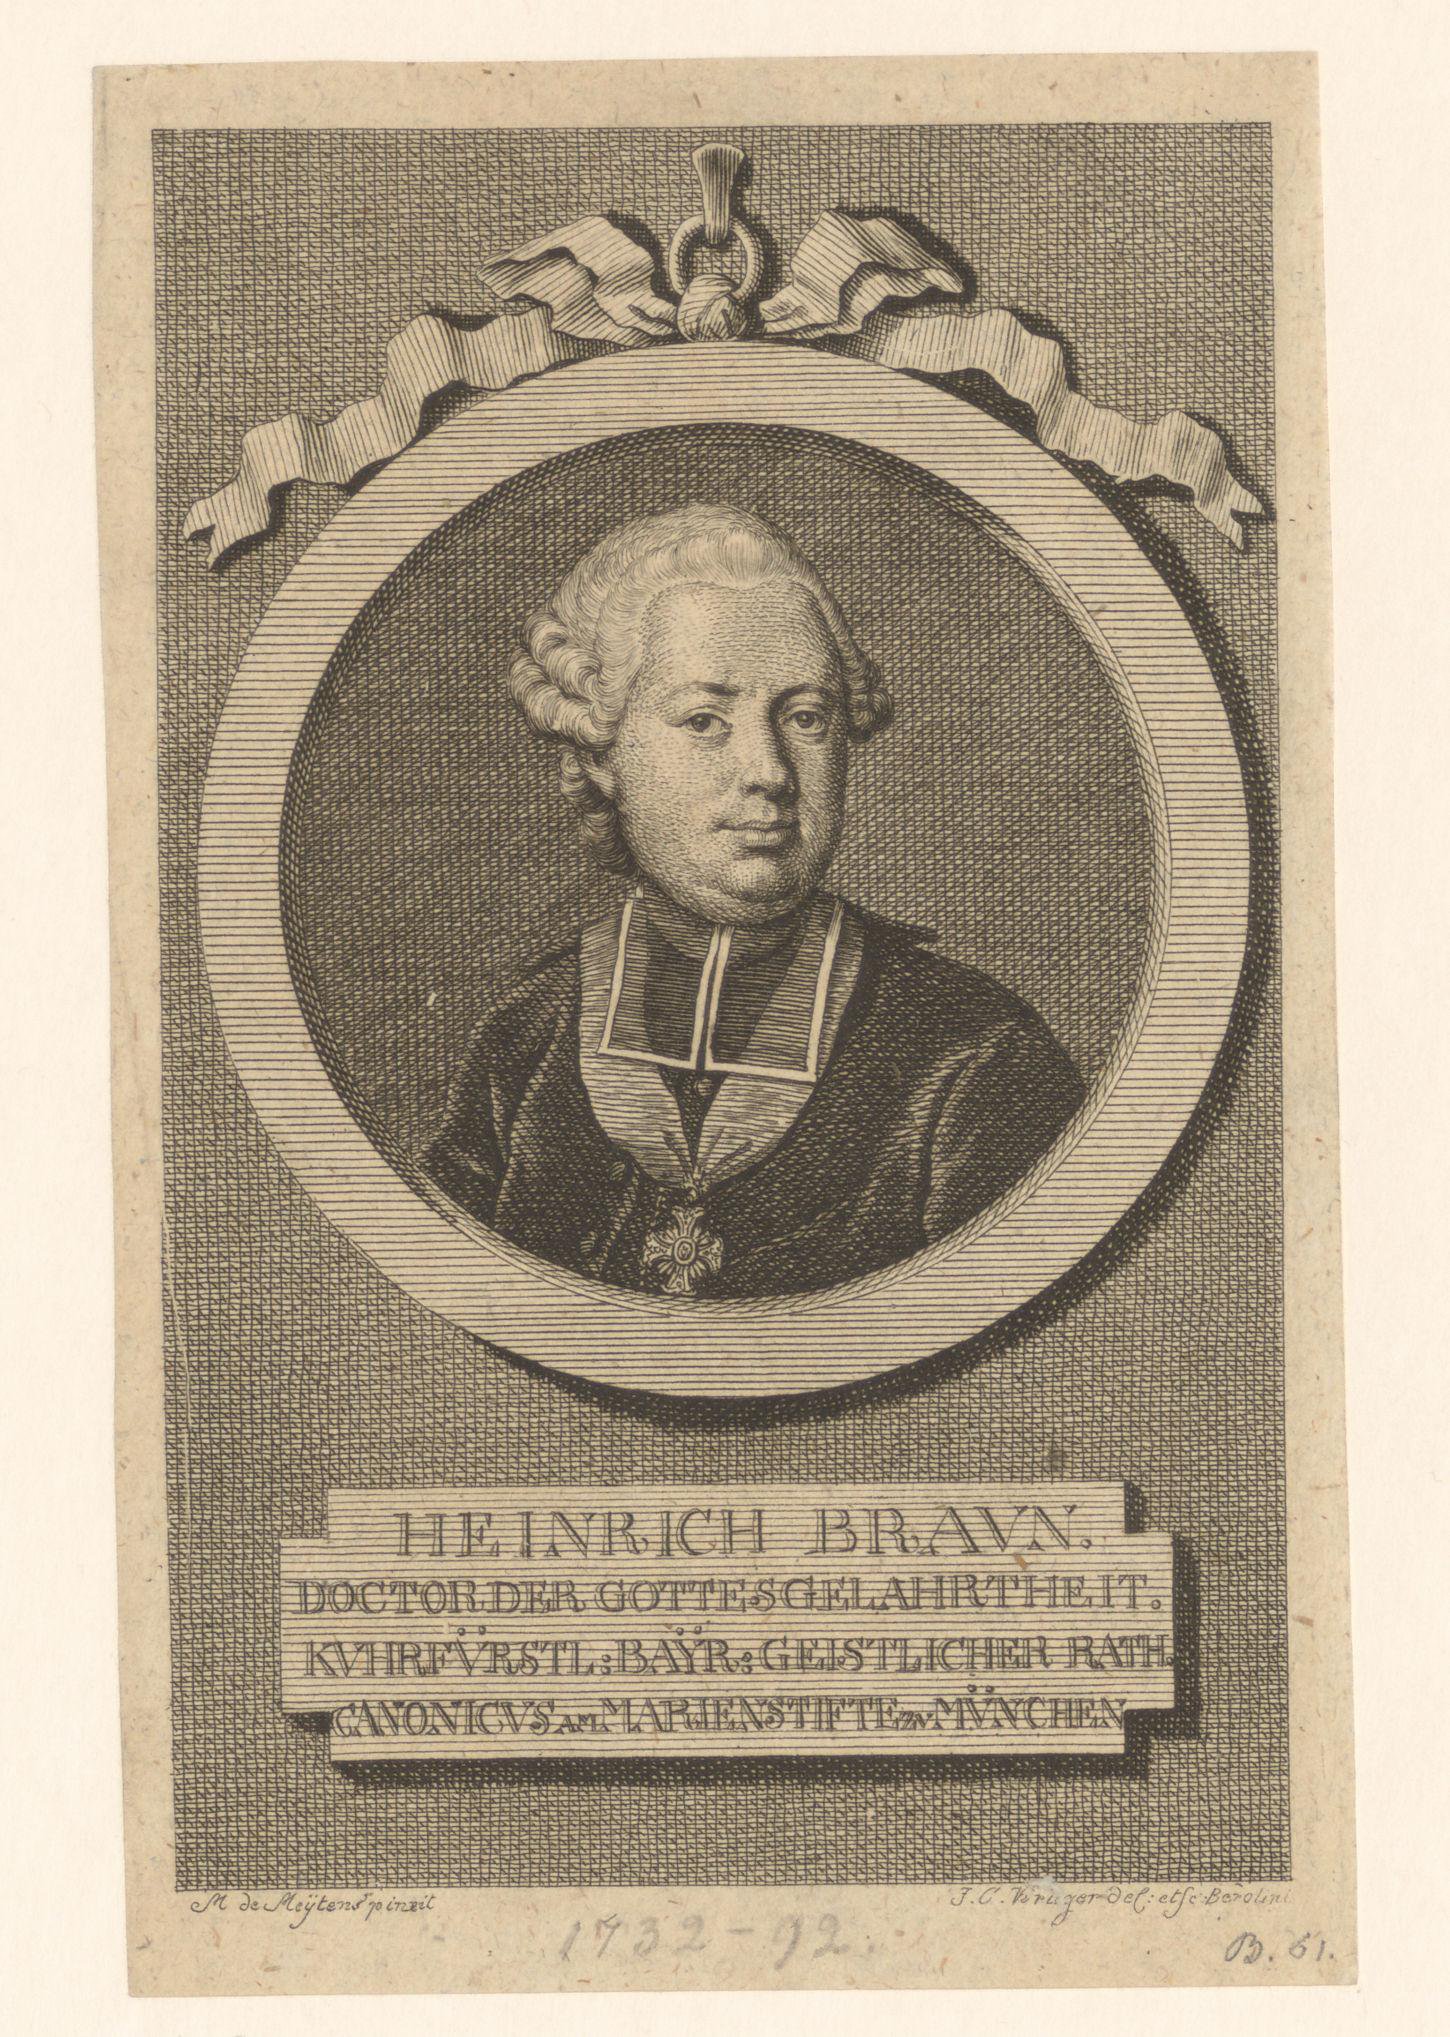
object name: print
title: Portret van Heinrich Braun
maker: johann conrad krüger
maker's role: artist, painter, print maker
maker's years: 1733-1791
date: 1743-1791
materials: paper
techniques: engraving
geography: berlin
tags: theologian, further education (+ portrait of teacher, professor), historical persons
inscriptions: collector's mark: Lugt 2228